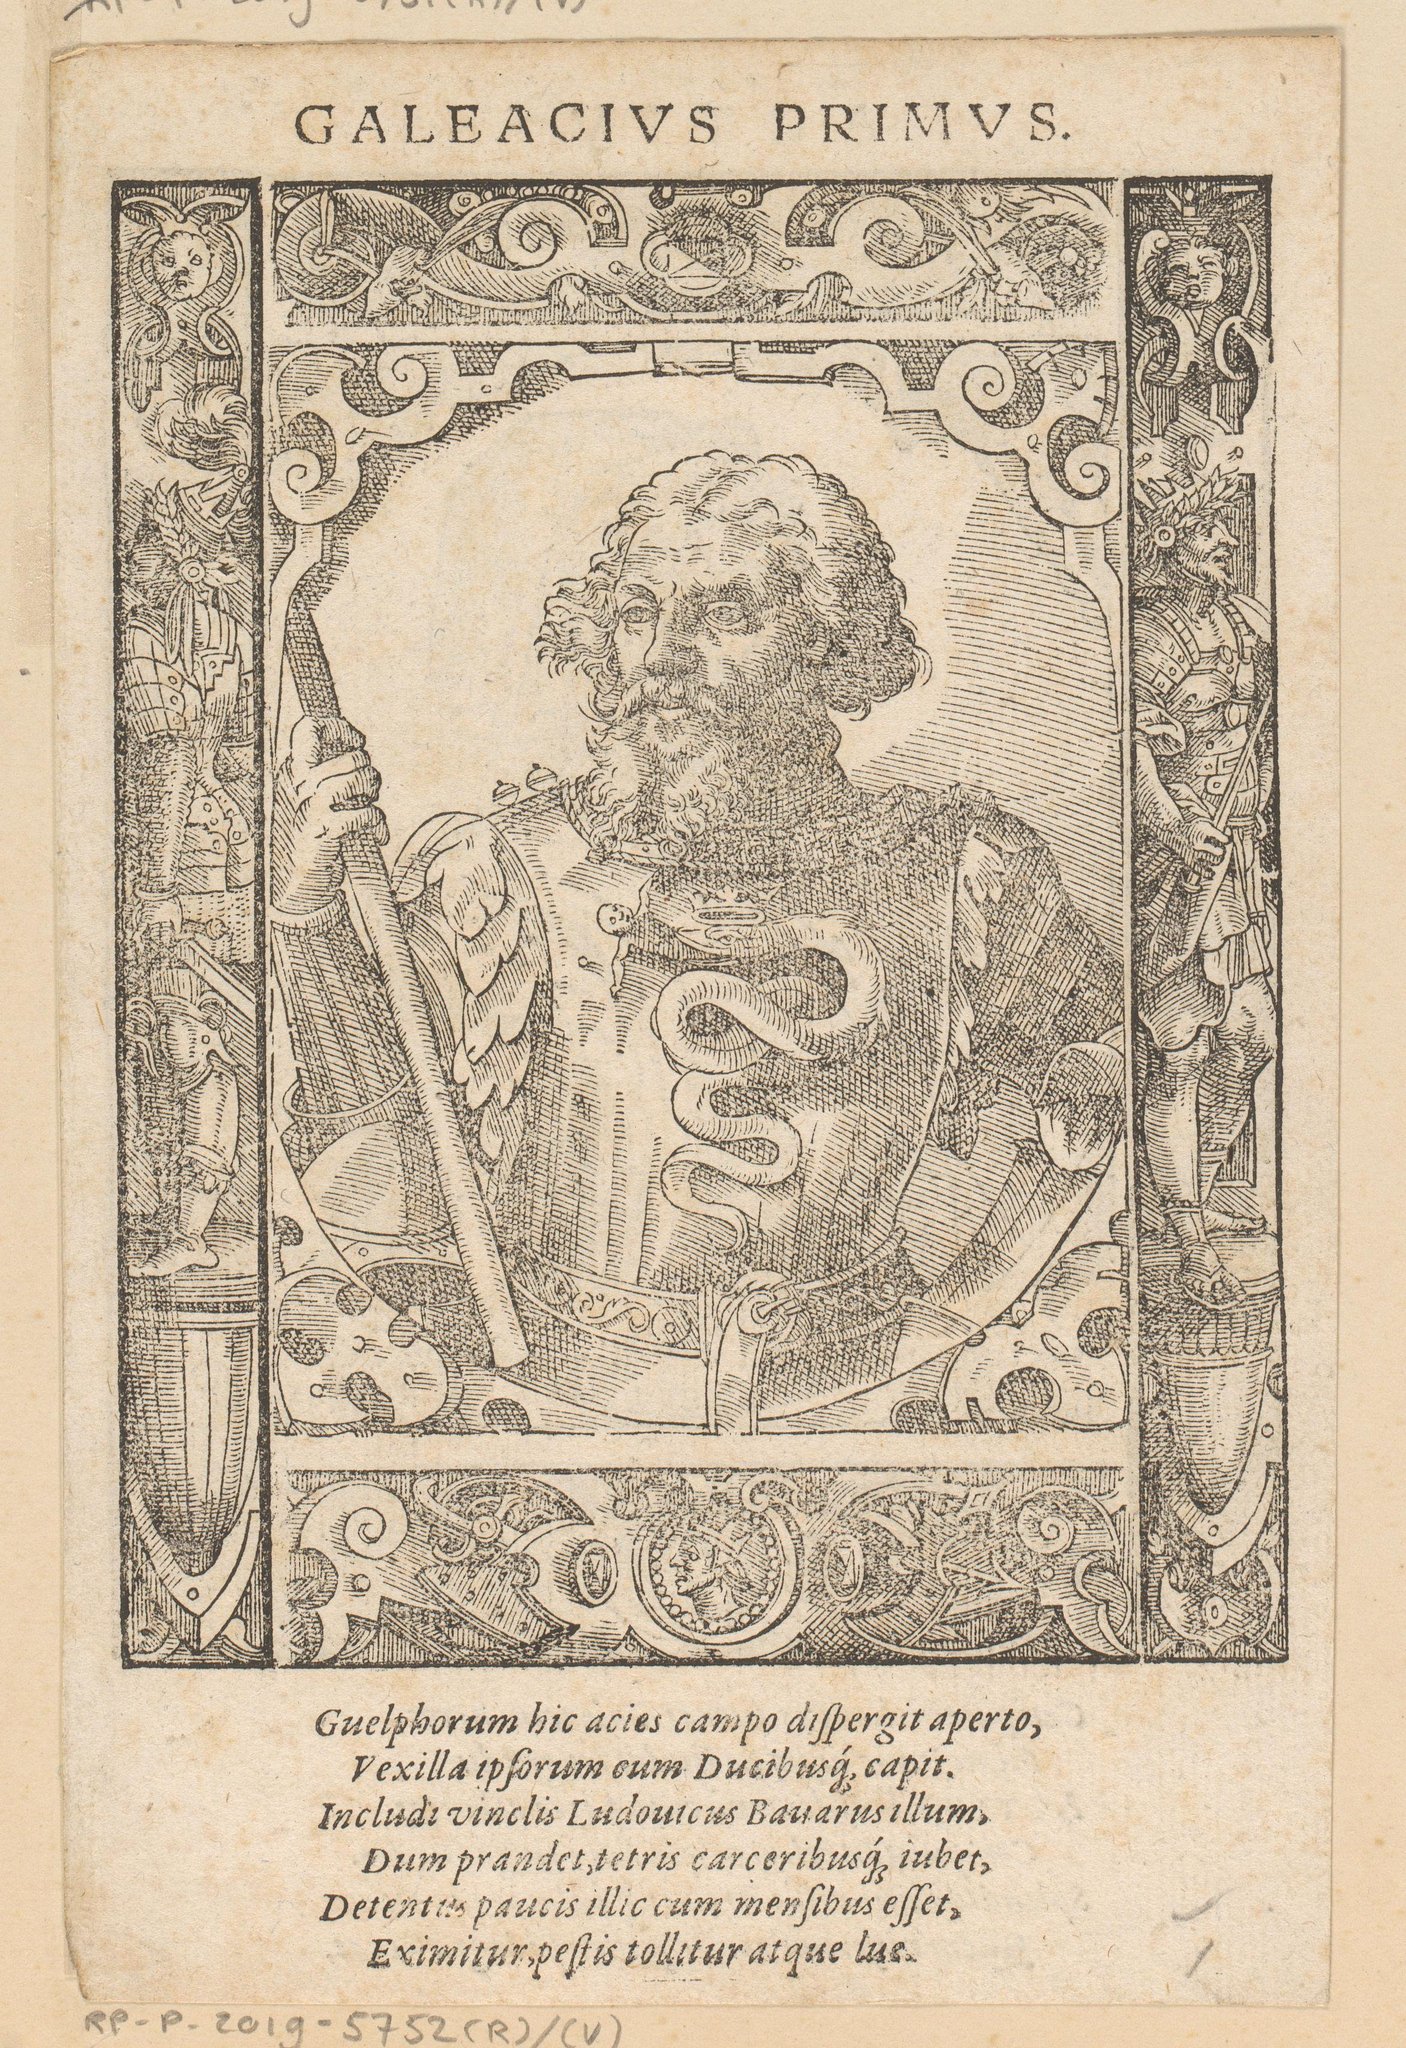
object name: print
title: Portret van Galeazzo I Visconti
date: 1589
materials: paper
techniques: letterpress printing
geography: basel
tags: armour, historical persons, baton of general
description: Prent uit: Thilo, Valentinus. Icones heroum bellica virtute maxime illustrium (...). Bazel: Konrad Waldkirch, 1589. Prent eerder verschenen in: Giovio, Paolo. Elogia virorum bellica virtute illustrium (...). Bazel: Peter Perna, 1575. Prent ook gebruikt in latere publicaties.